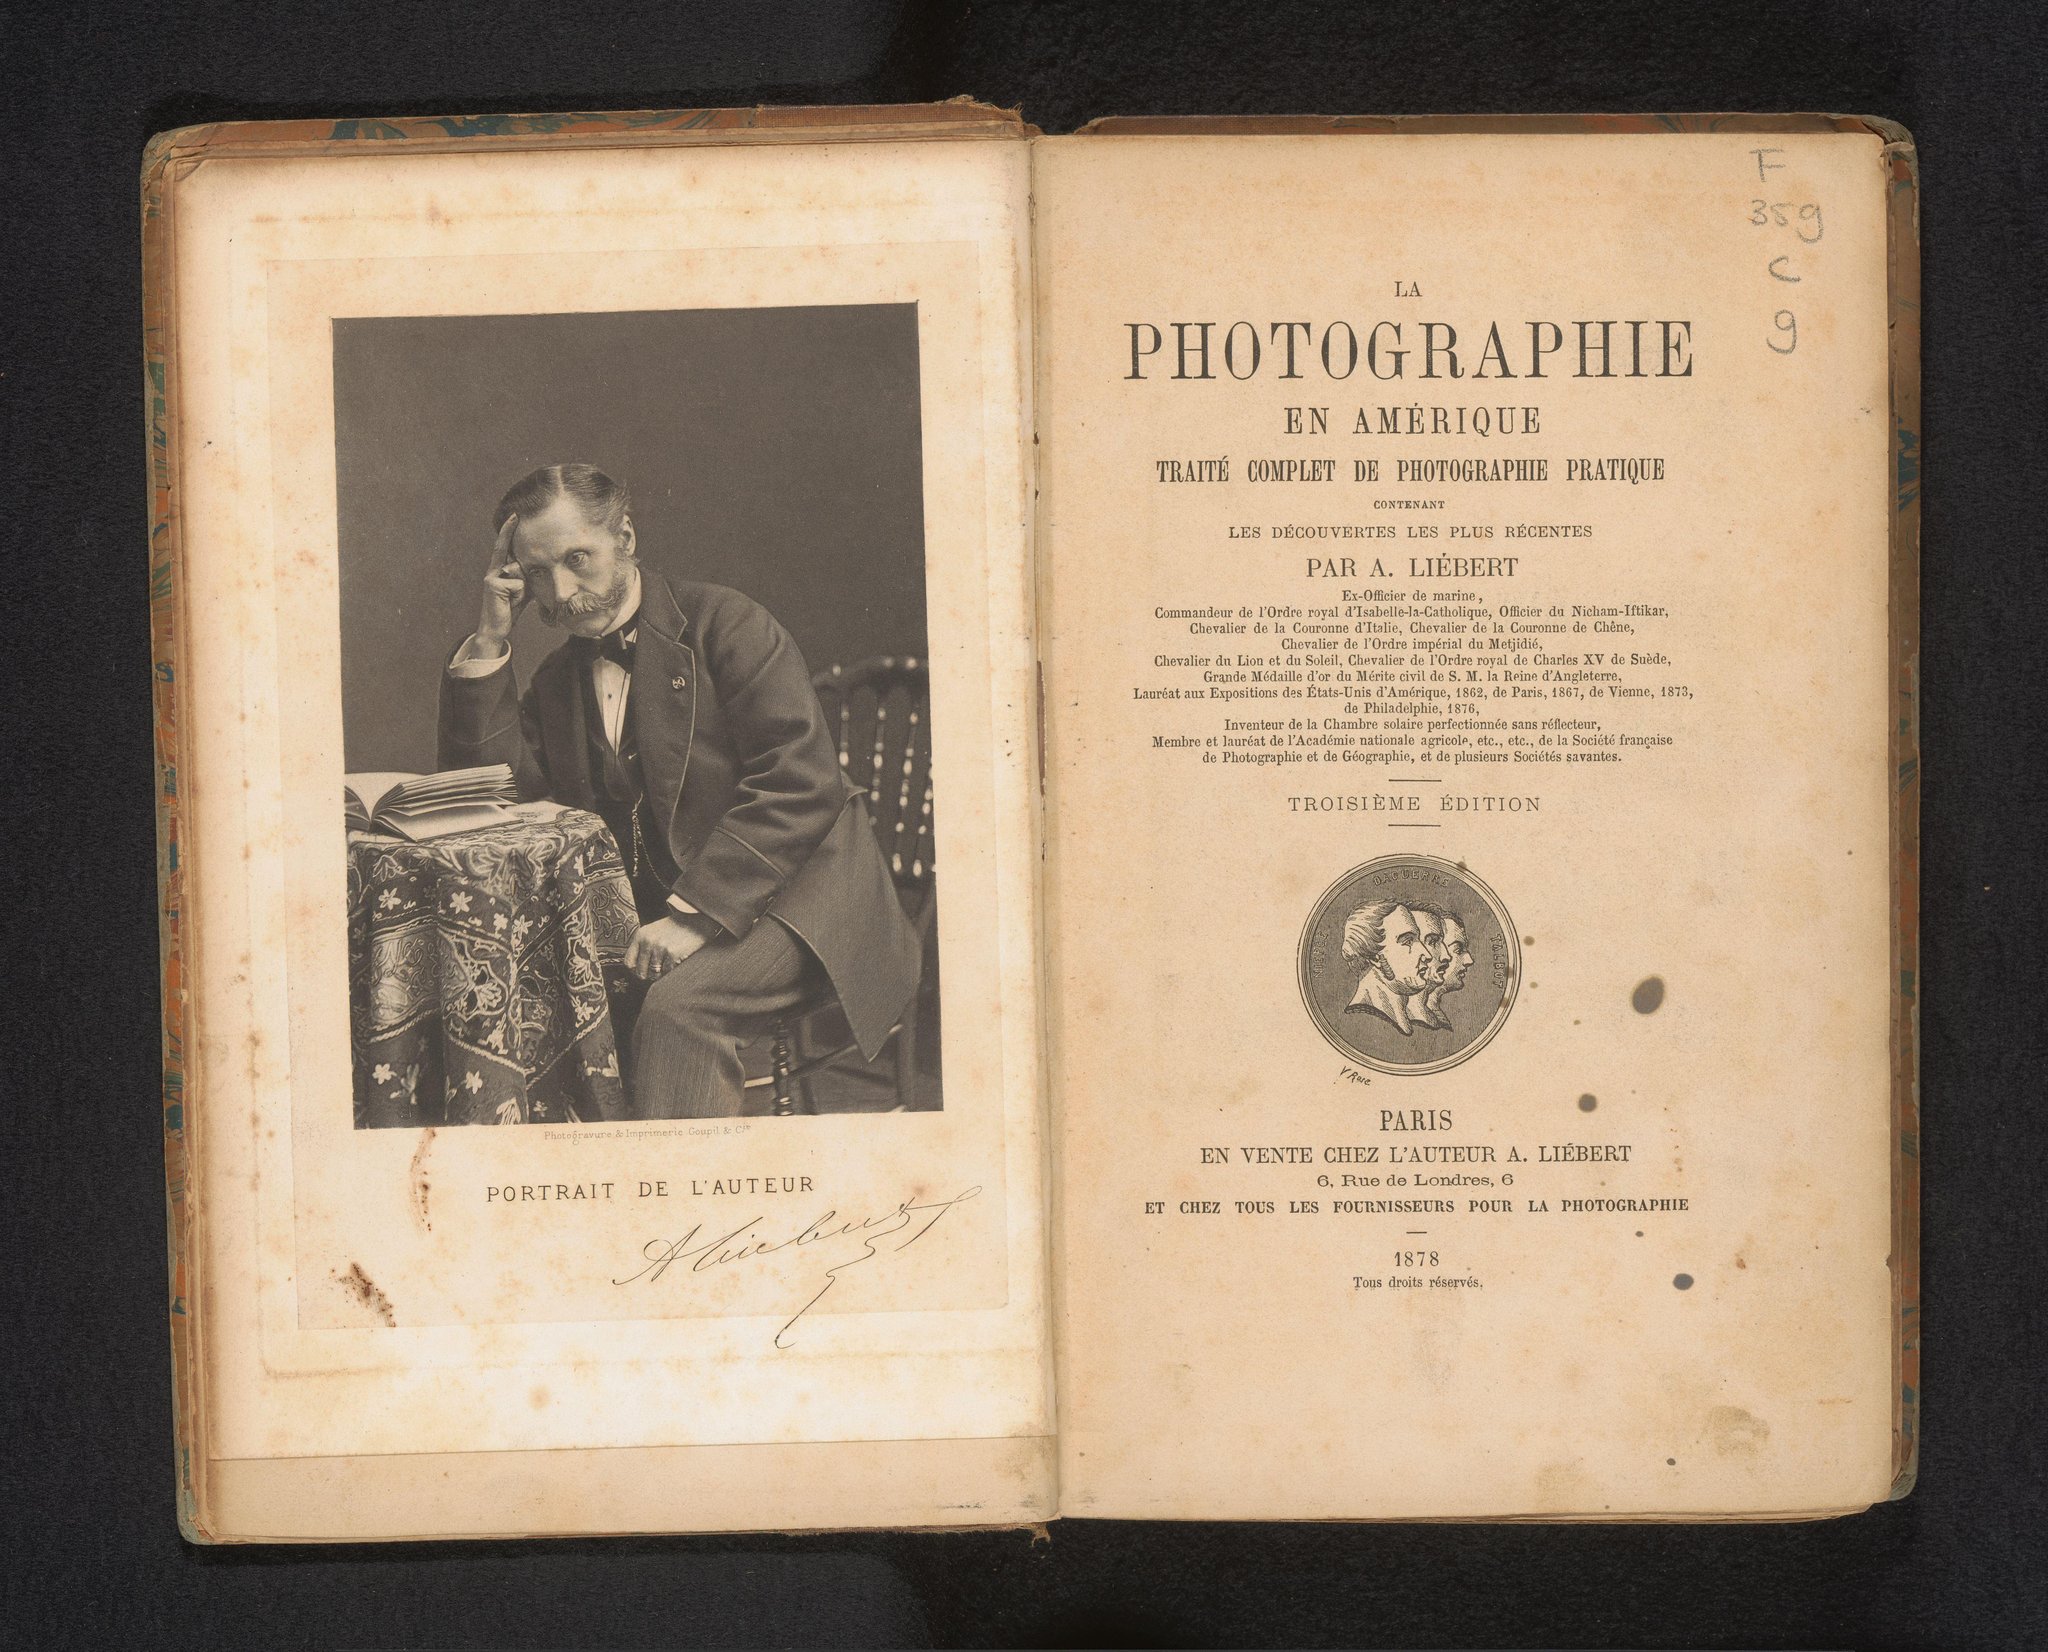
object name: page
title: Portrait de l'Auteur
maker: Anonymous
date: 1873-1878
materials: paper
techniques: photoaquatint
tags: paris, alphonse-justin liébert, historical persons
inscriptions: signature: ‘A Liebert’